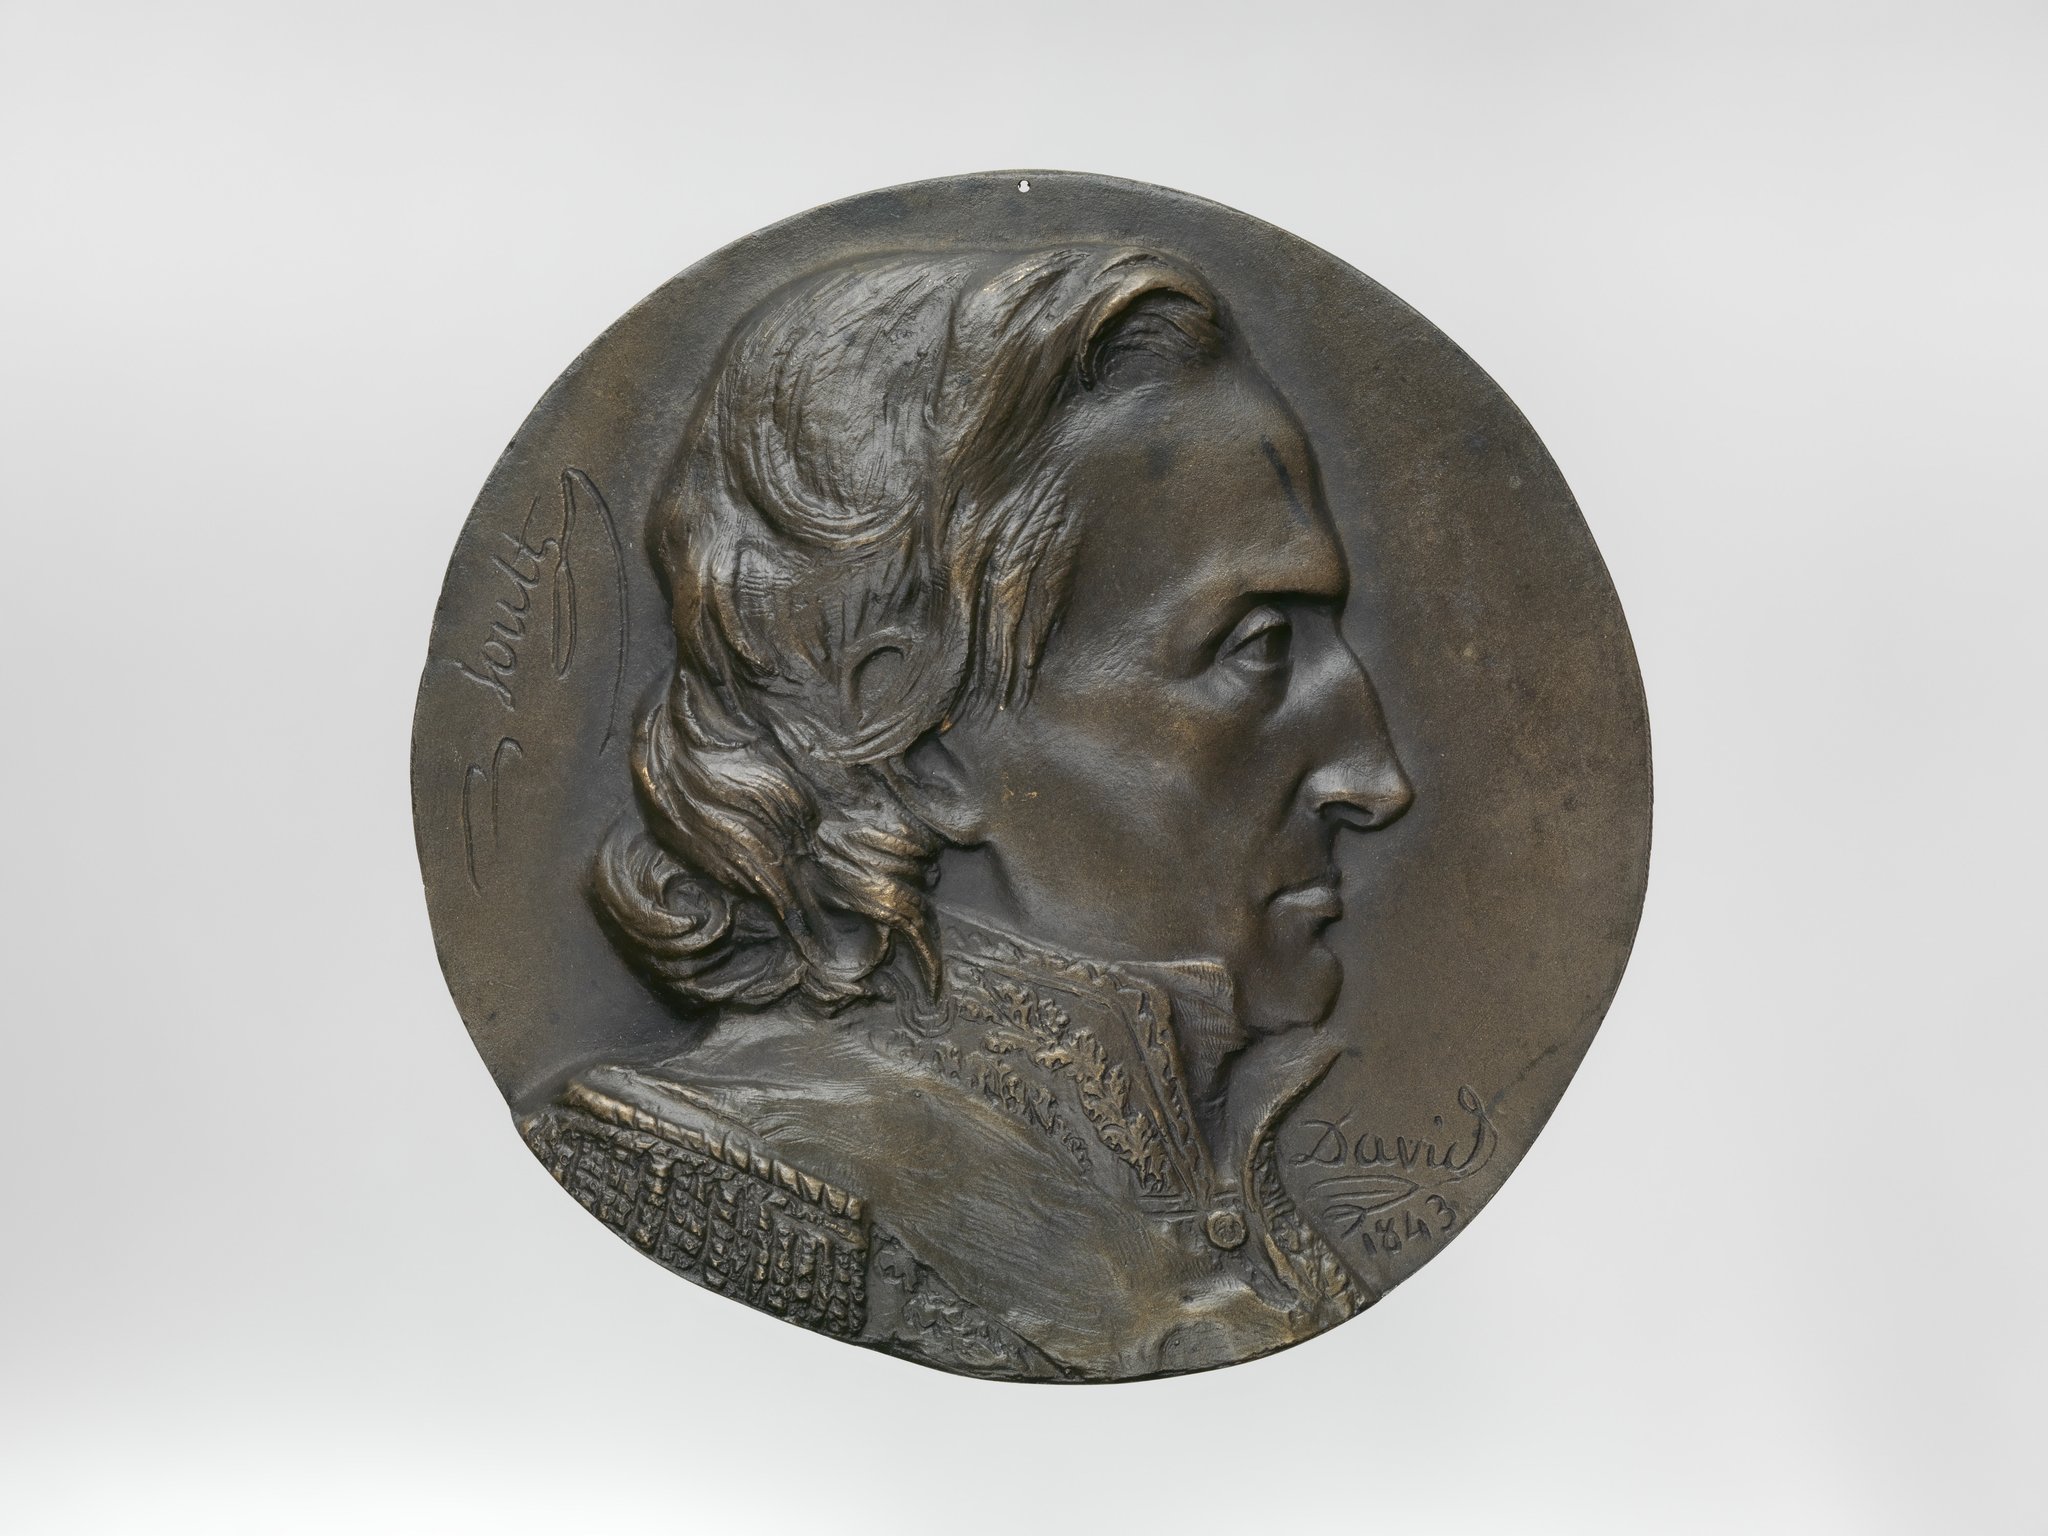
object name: medallion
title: Marshal Soult (1769–1851)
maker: pierre jean david d'angers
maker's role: maker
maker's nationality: french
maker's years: 1788-1856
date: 1843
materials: bronze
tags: men,profiles